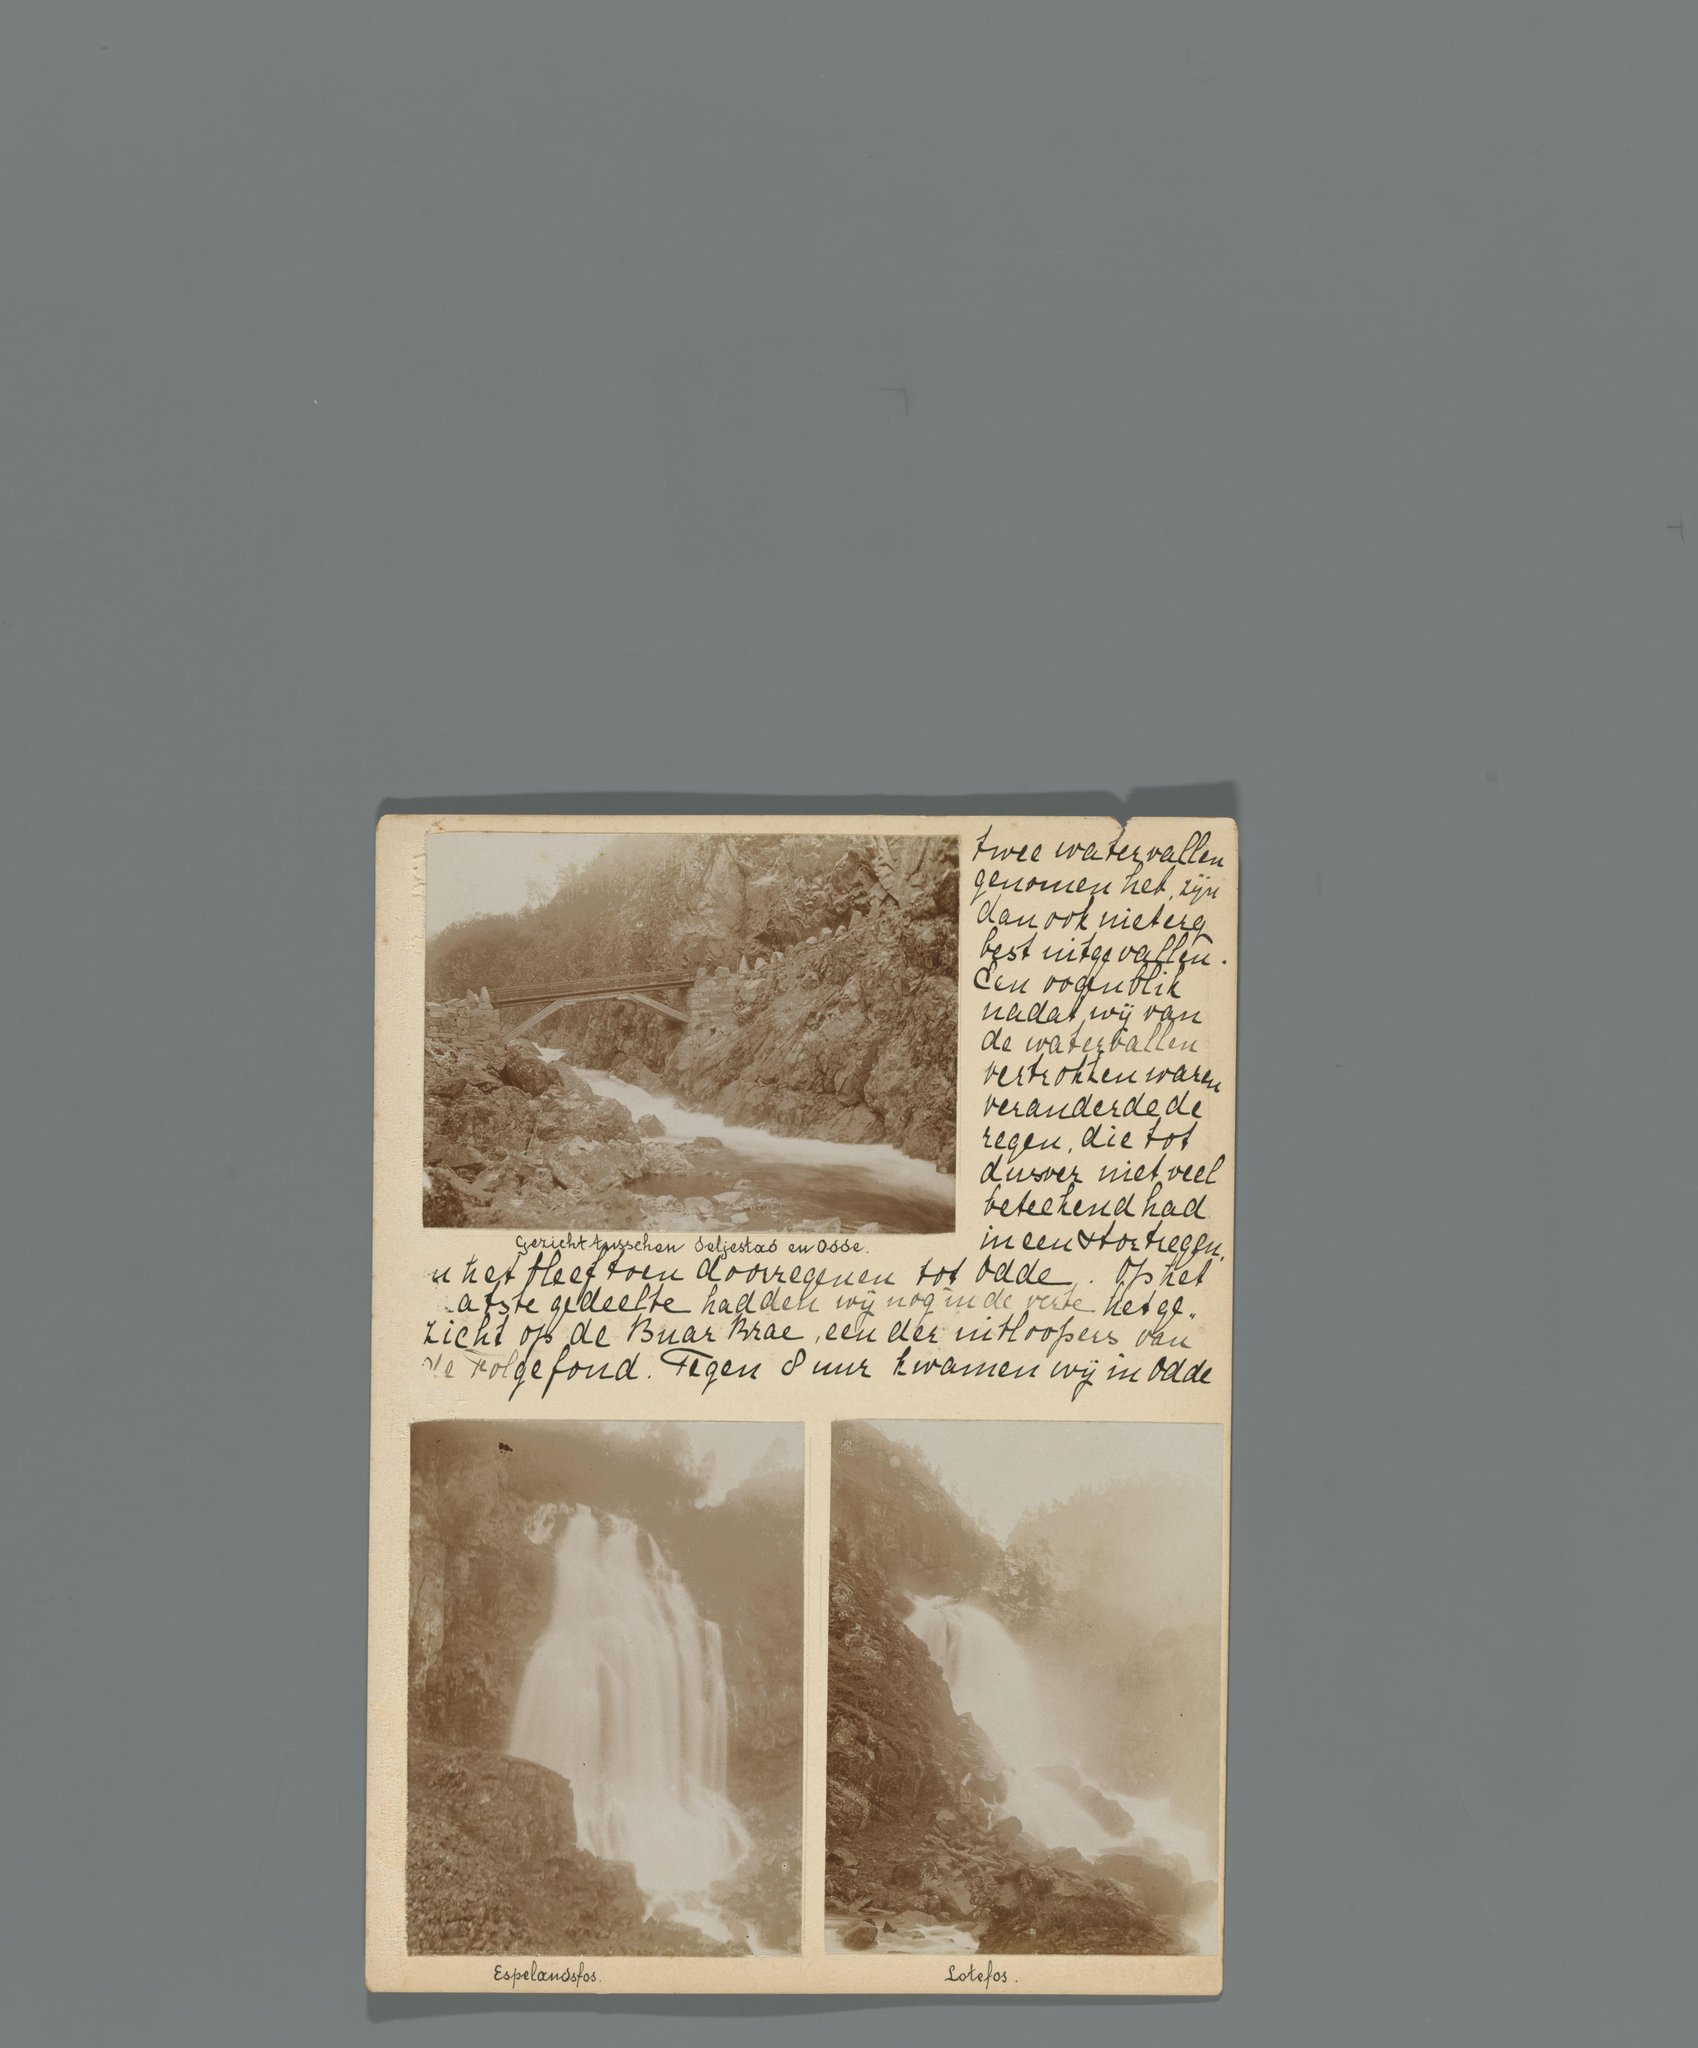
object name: page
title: Negentiende pagina van een dagboek van een reis door Noorwegen met drie foto's van een brug en de watervallen Låtefossen en Espelandsfossen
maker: hendrik herman van den berg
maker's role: amateurfotograaf, jurist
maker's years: 1875-1944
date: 1895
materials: paper, ink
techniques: pen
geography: odda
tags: batavia, amsterdam, hendrik herman van den berg, waterfall, ravine, chasm, abyss, canyon, handwriting, written text, 'en route', traveller under way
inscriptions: caption: ‘Gorsvand./ Gorsvand.’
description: Negentiende pagina van een dagboek met het verslag van een reis door Noorwegen gemaakt door Hendrik Herman van den Berg en zijn neef Guillaume Louis Jacques Holle tussen 5 en 20 juli 1895. Op het dagboekblad zijn drie foto's geplakt met gezichten op de watervallen Låtefossen en Espelandsfossen en een gezicht op een brug tussen Seljestad en Odda.